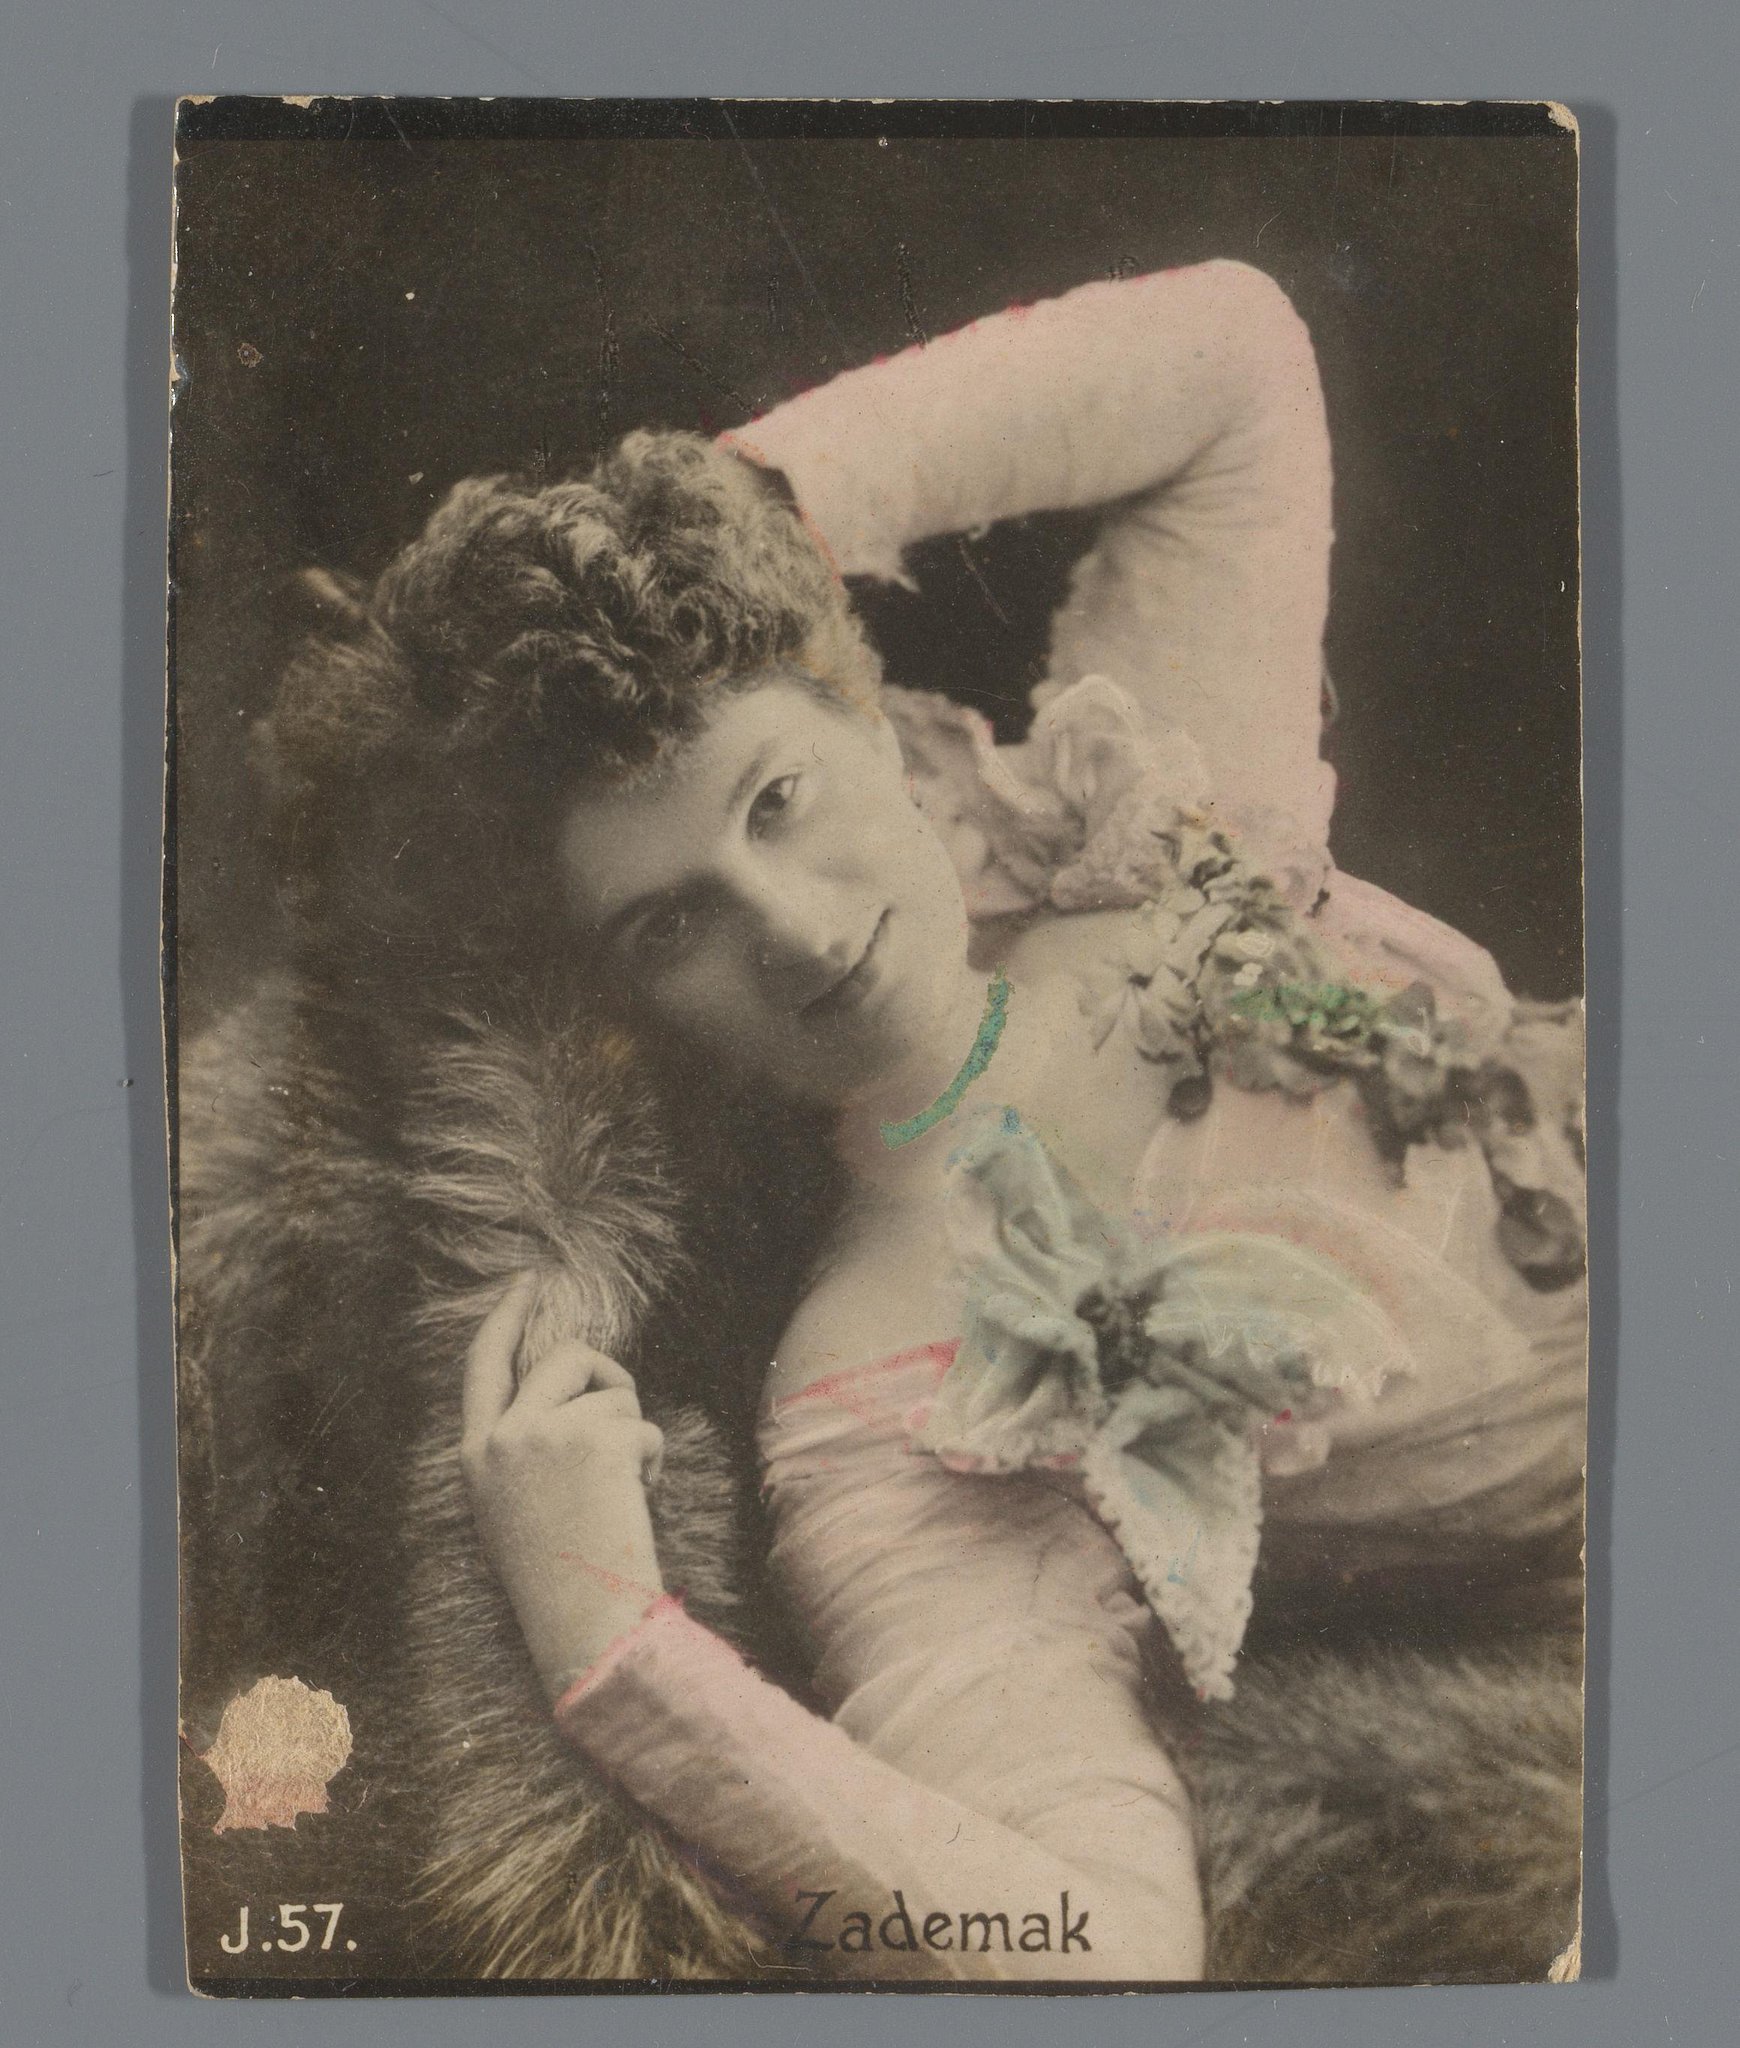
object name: photograph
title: Portret van een onbekende vrouw, aangeduid als Zademak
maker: Anonymous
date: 1890-1910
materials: photographic support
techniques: gelatin silver print, hand coloring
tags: historical persons - bb - woman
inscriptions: number: ‘J. 57.’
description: Dergelijke foto's stonden bekend als 'zwartjes'. Men verkreeg ze bij aanschaf van bepaalde merken thee, cacao, sigaretten, beschuit, etc. om te verzamelen. Er waren speciaal voor de 'zwartjes' vervaardigde verzamelalbums in omloop.